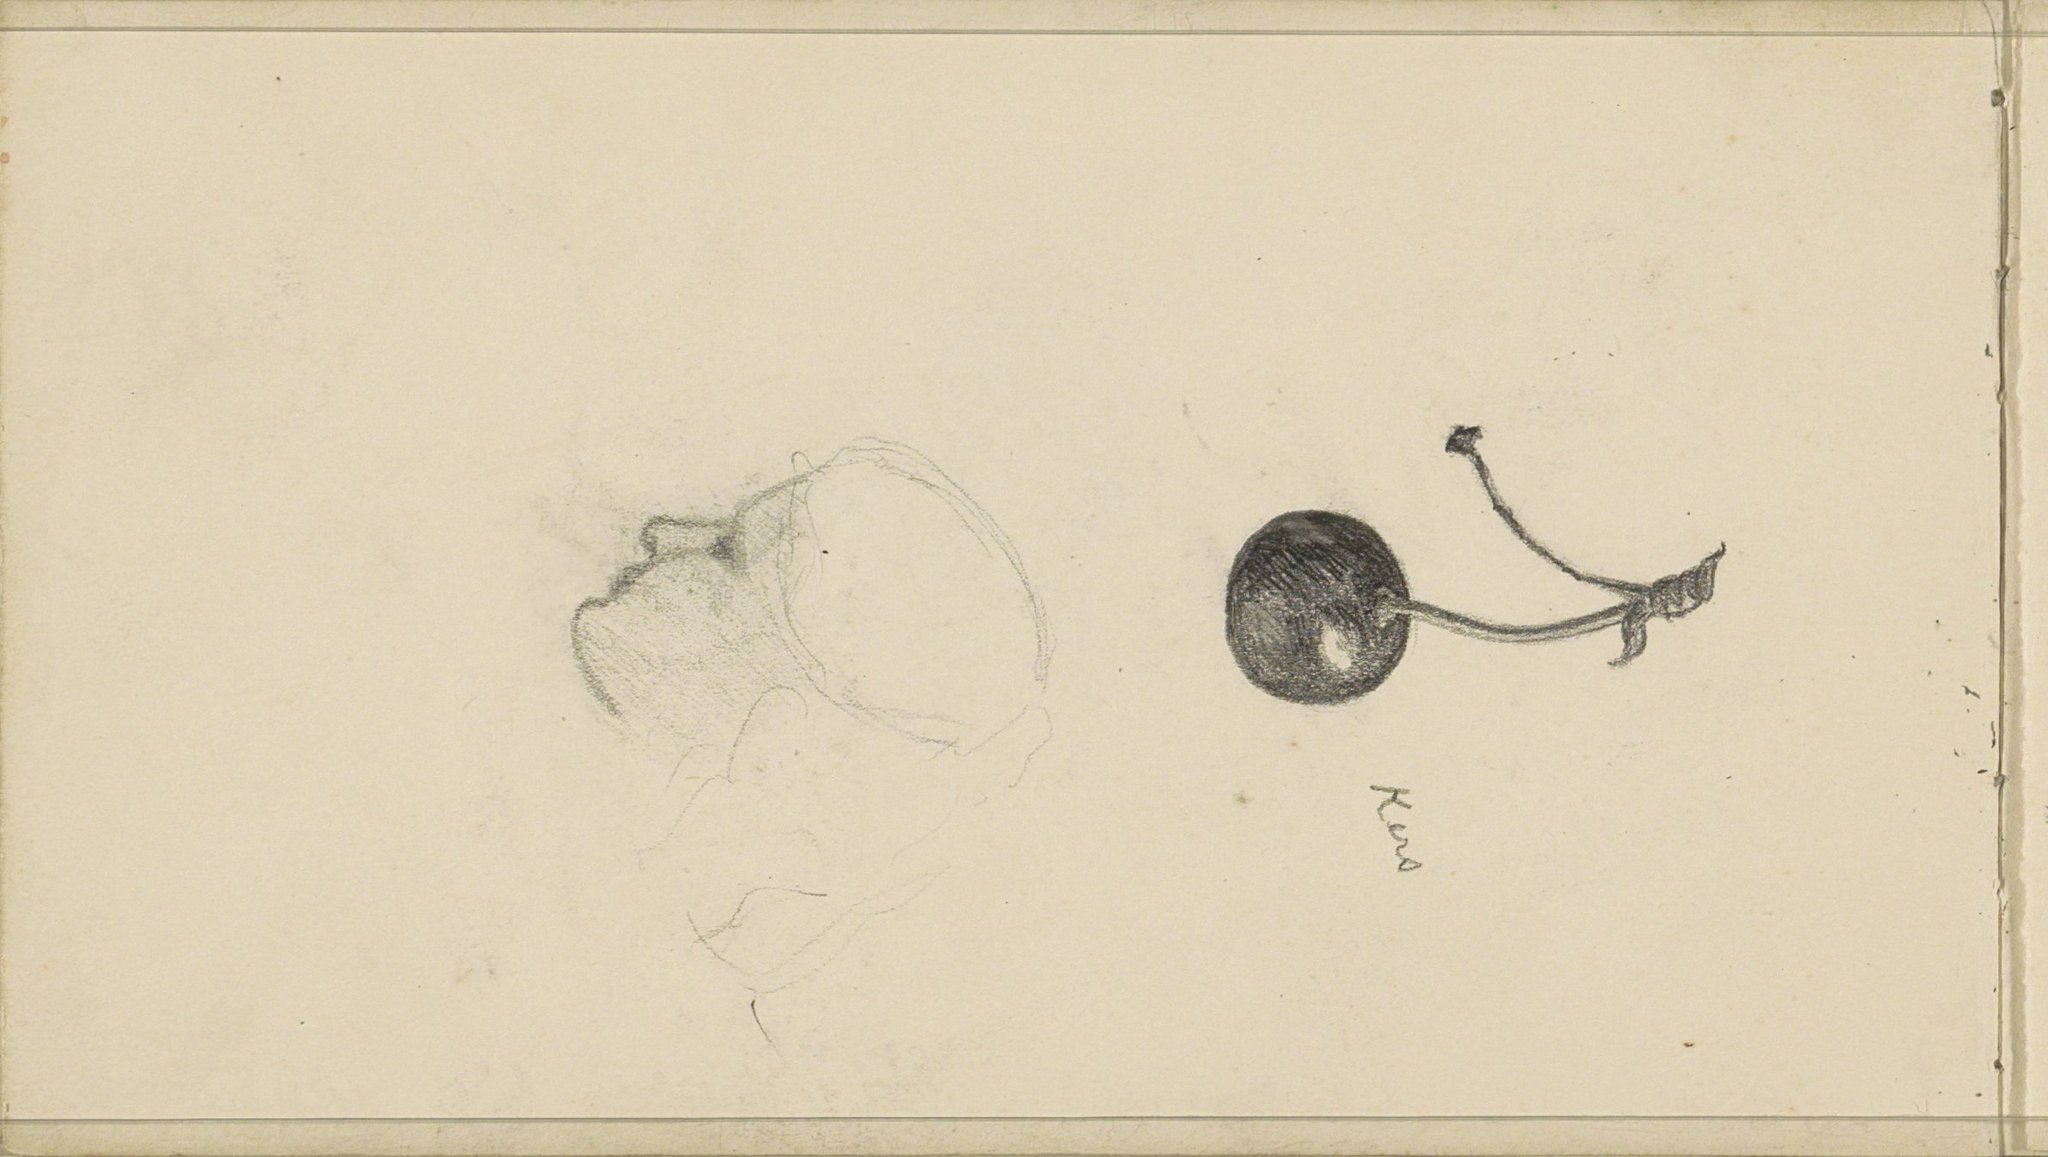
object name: sketchbook leaf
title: Kers en een vrouwenkop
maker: julie de graag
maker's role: draughtsman, print maker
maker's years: 1877-1924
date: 1892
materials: paper, pencil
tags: head (human), adult woman, fruits: cherry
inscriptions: annotation: ‘Kers’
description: Blad 19 verso uit een schetsboek met 22 bladen.